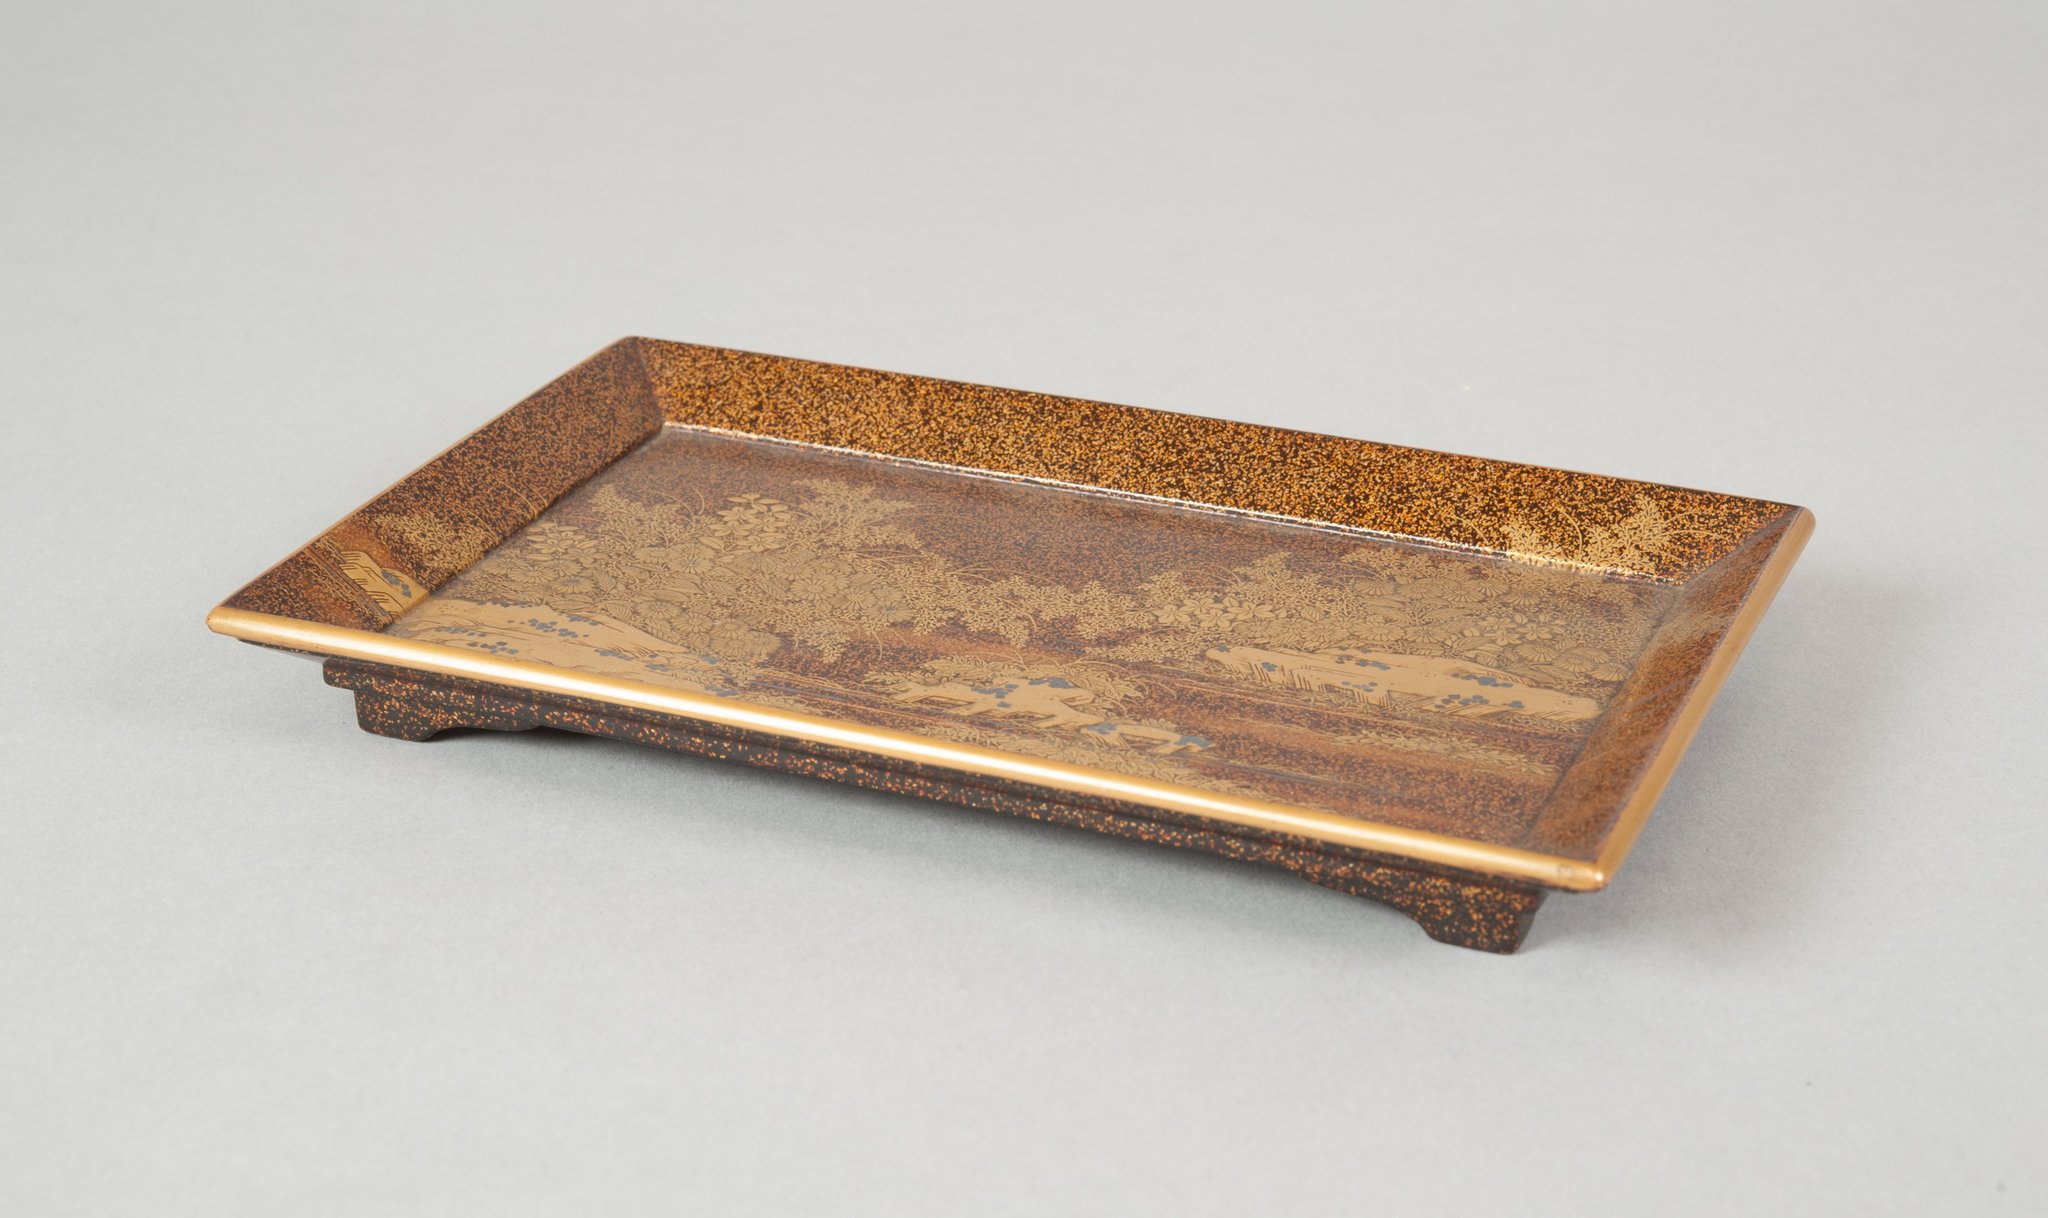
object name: tray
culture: japanese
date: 1701-1800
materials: gold, lacquer